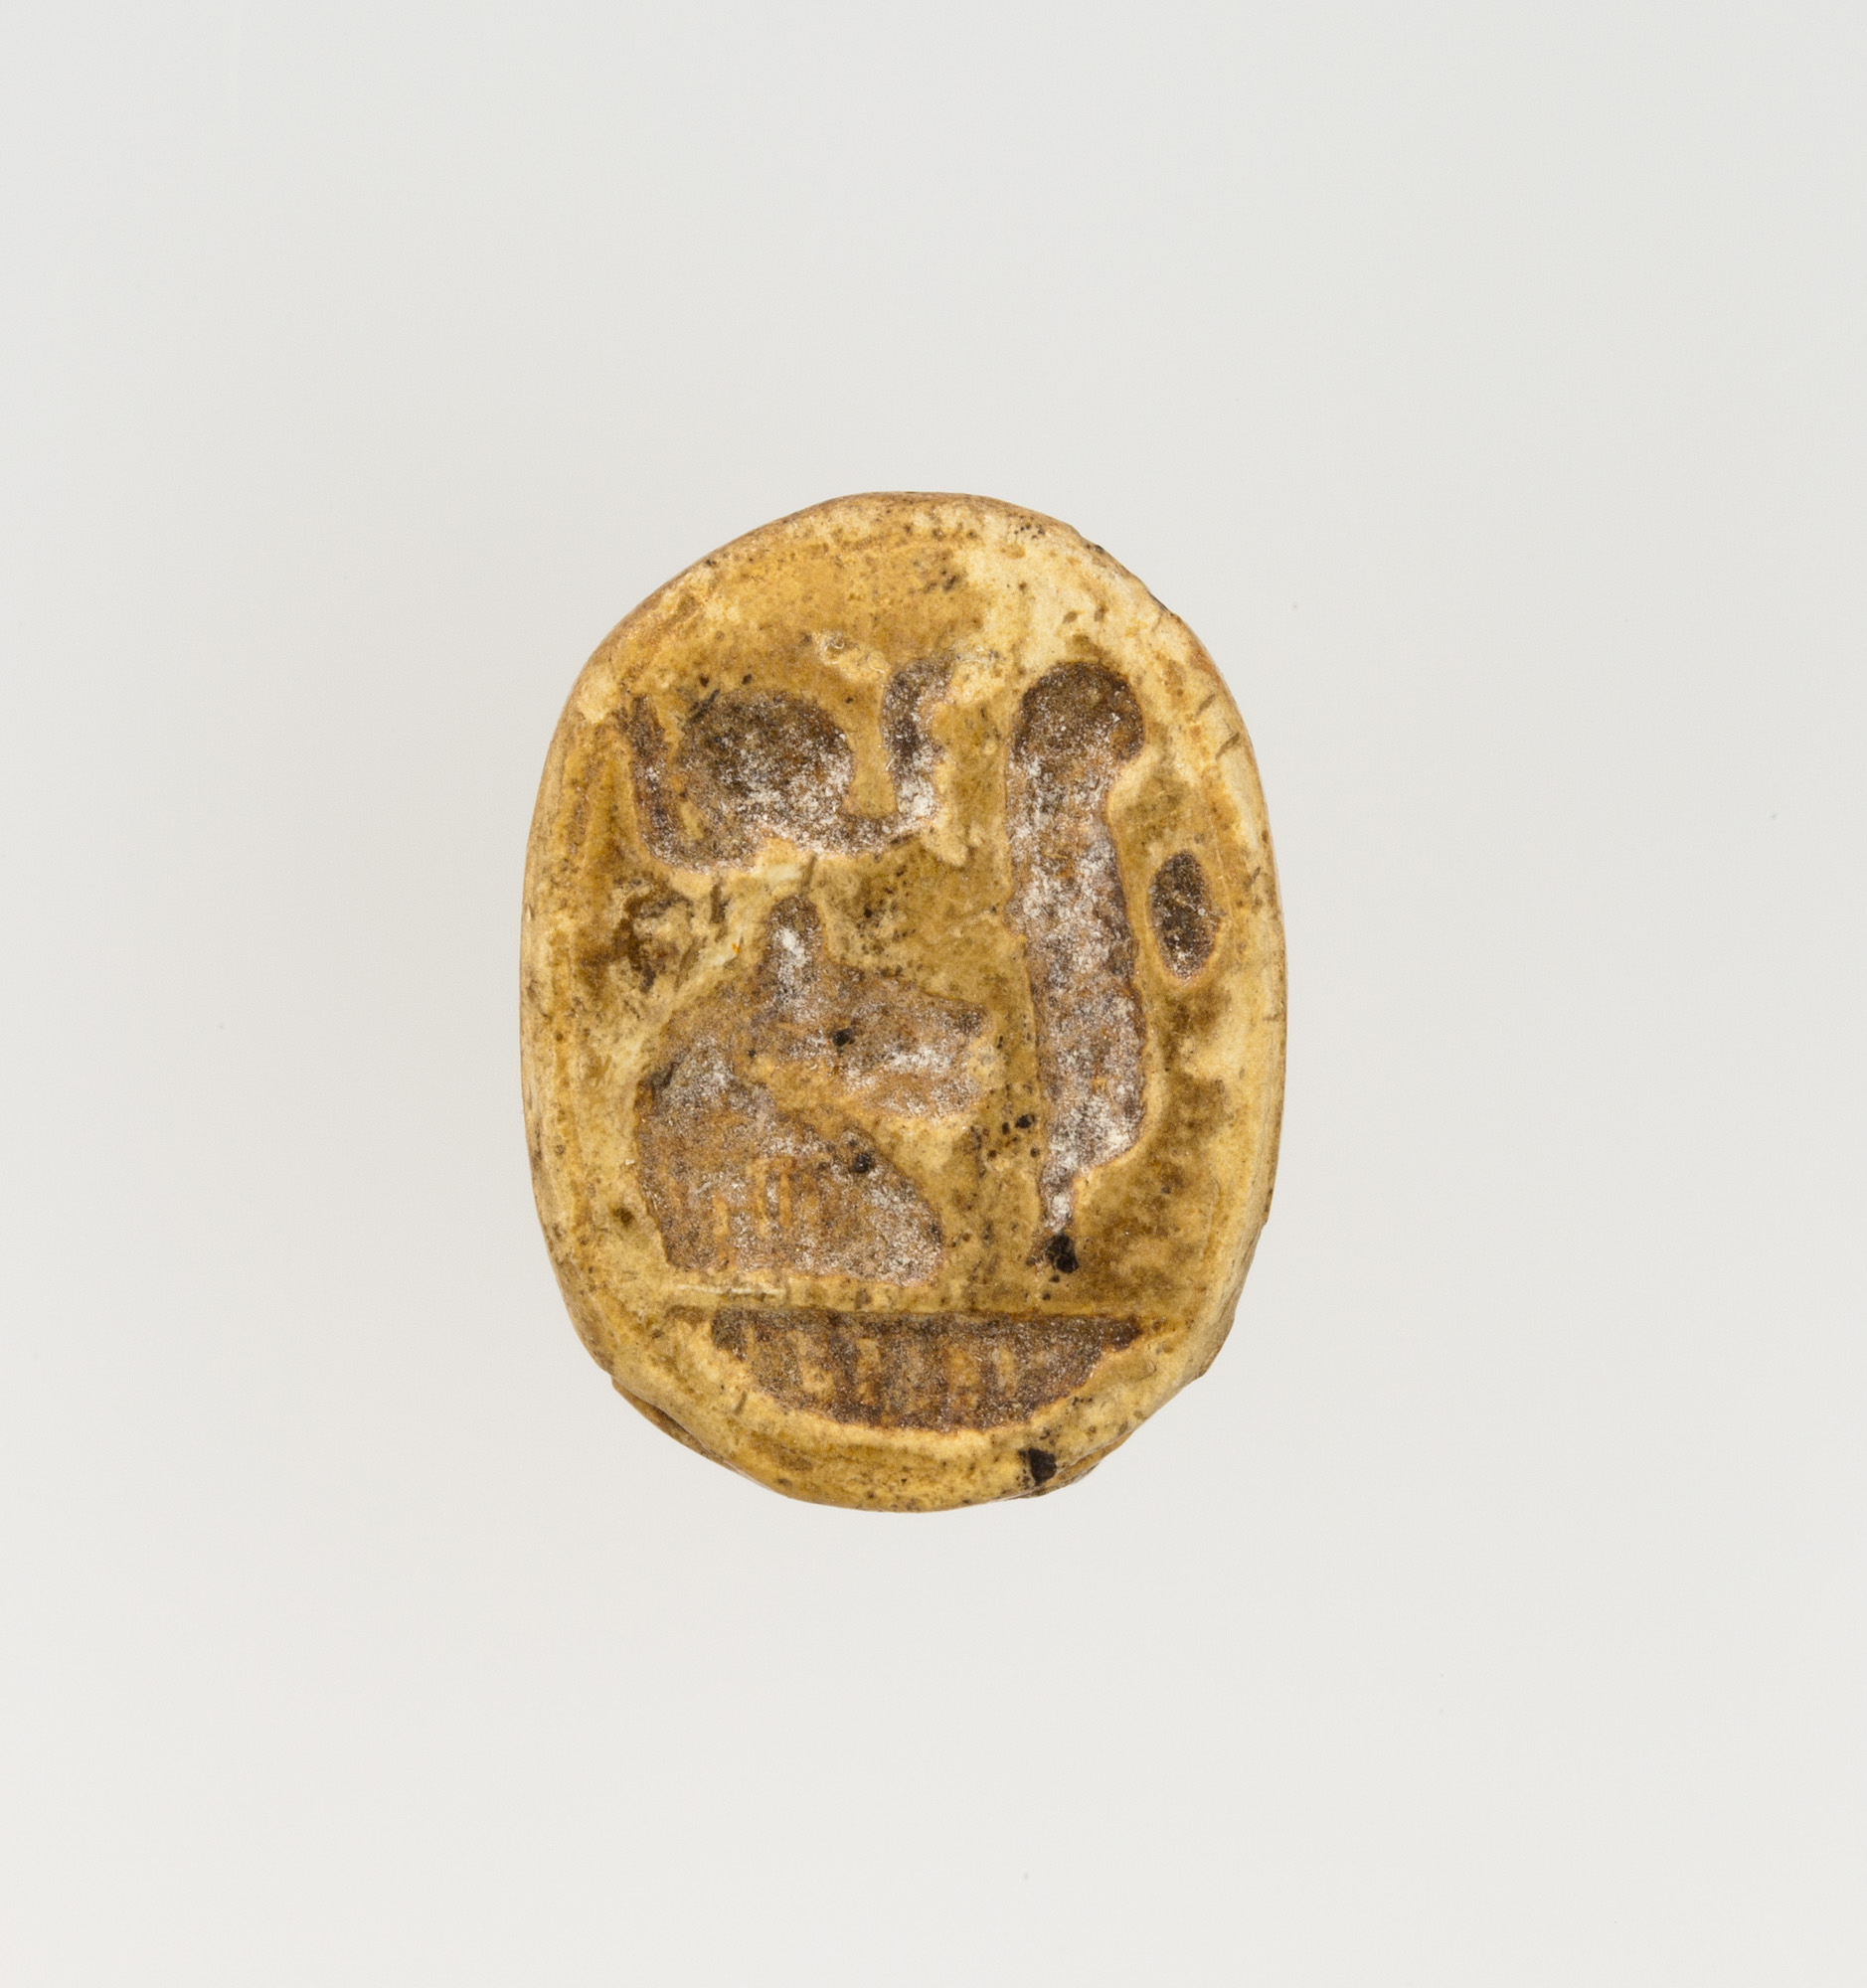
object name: scarab, ahmose, nebpehtyre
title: Scarab Inscribed with the Throne Name of Ahmose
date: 1550-1525 BCE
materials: faience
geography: egypt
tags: scarabs